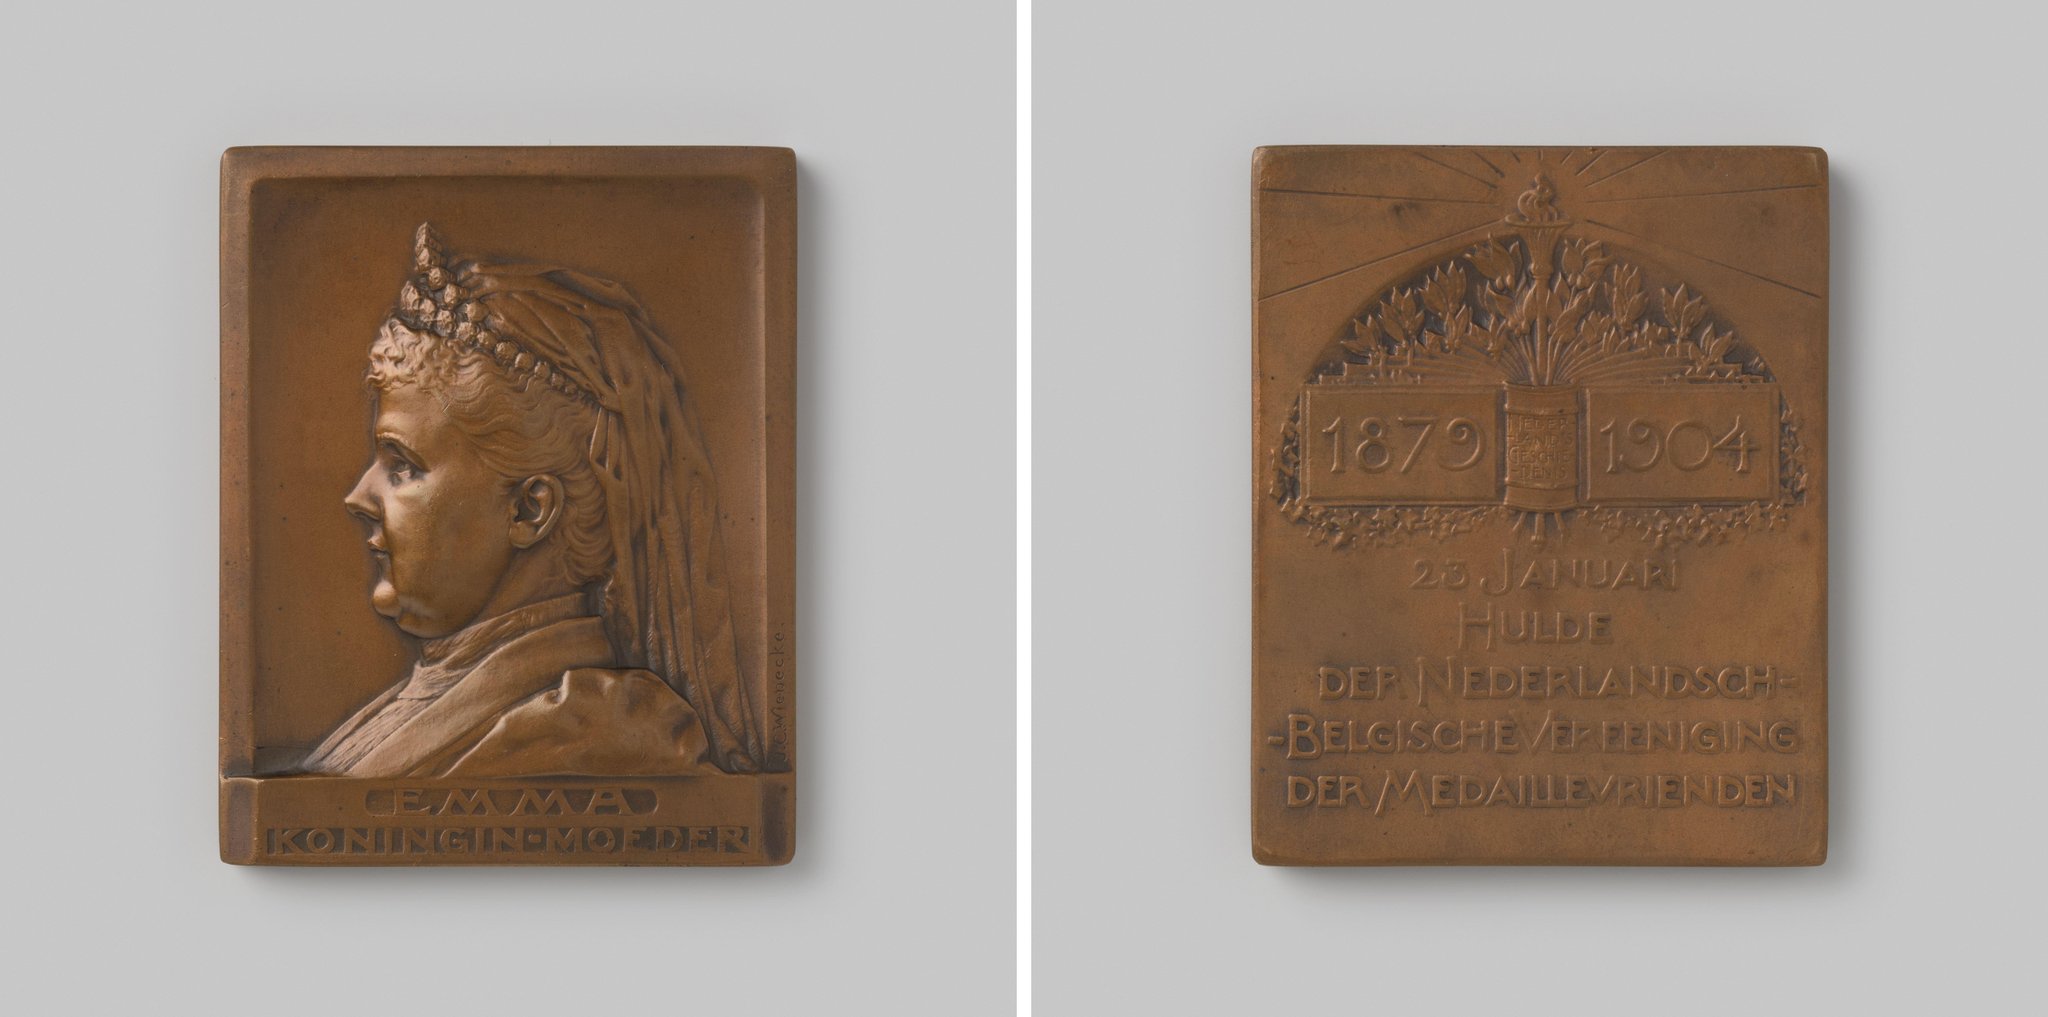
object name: history medal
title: Vijfentwintigjarig Nederlanderschap van Koningin Emma 1904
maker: johannes cornelis wienecke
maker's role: medailleur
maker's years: 1872-1945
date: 1904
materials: bronze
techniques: striking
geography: utrecht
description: Rechthoekige dikke bronzen plakette, op de voorzijde het gekroonde en gesluierde borstbeeld van Emma naar links, onderaan een balk met tekst, op de keerzijde de rugzijde van een opengeslagen boek, waaruit een stralende fakkel steekt, op een halve cirkel met lauwer- en klimoptakken waaronder vijf regels tekst.